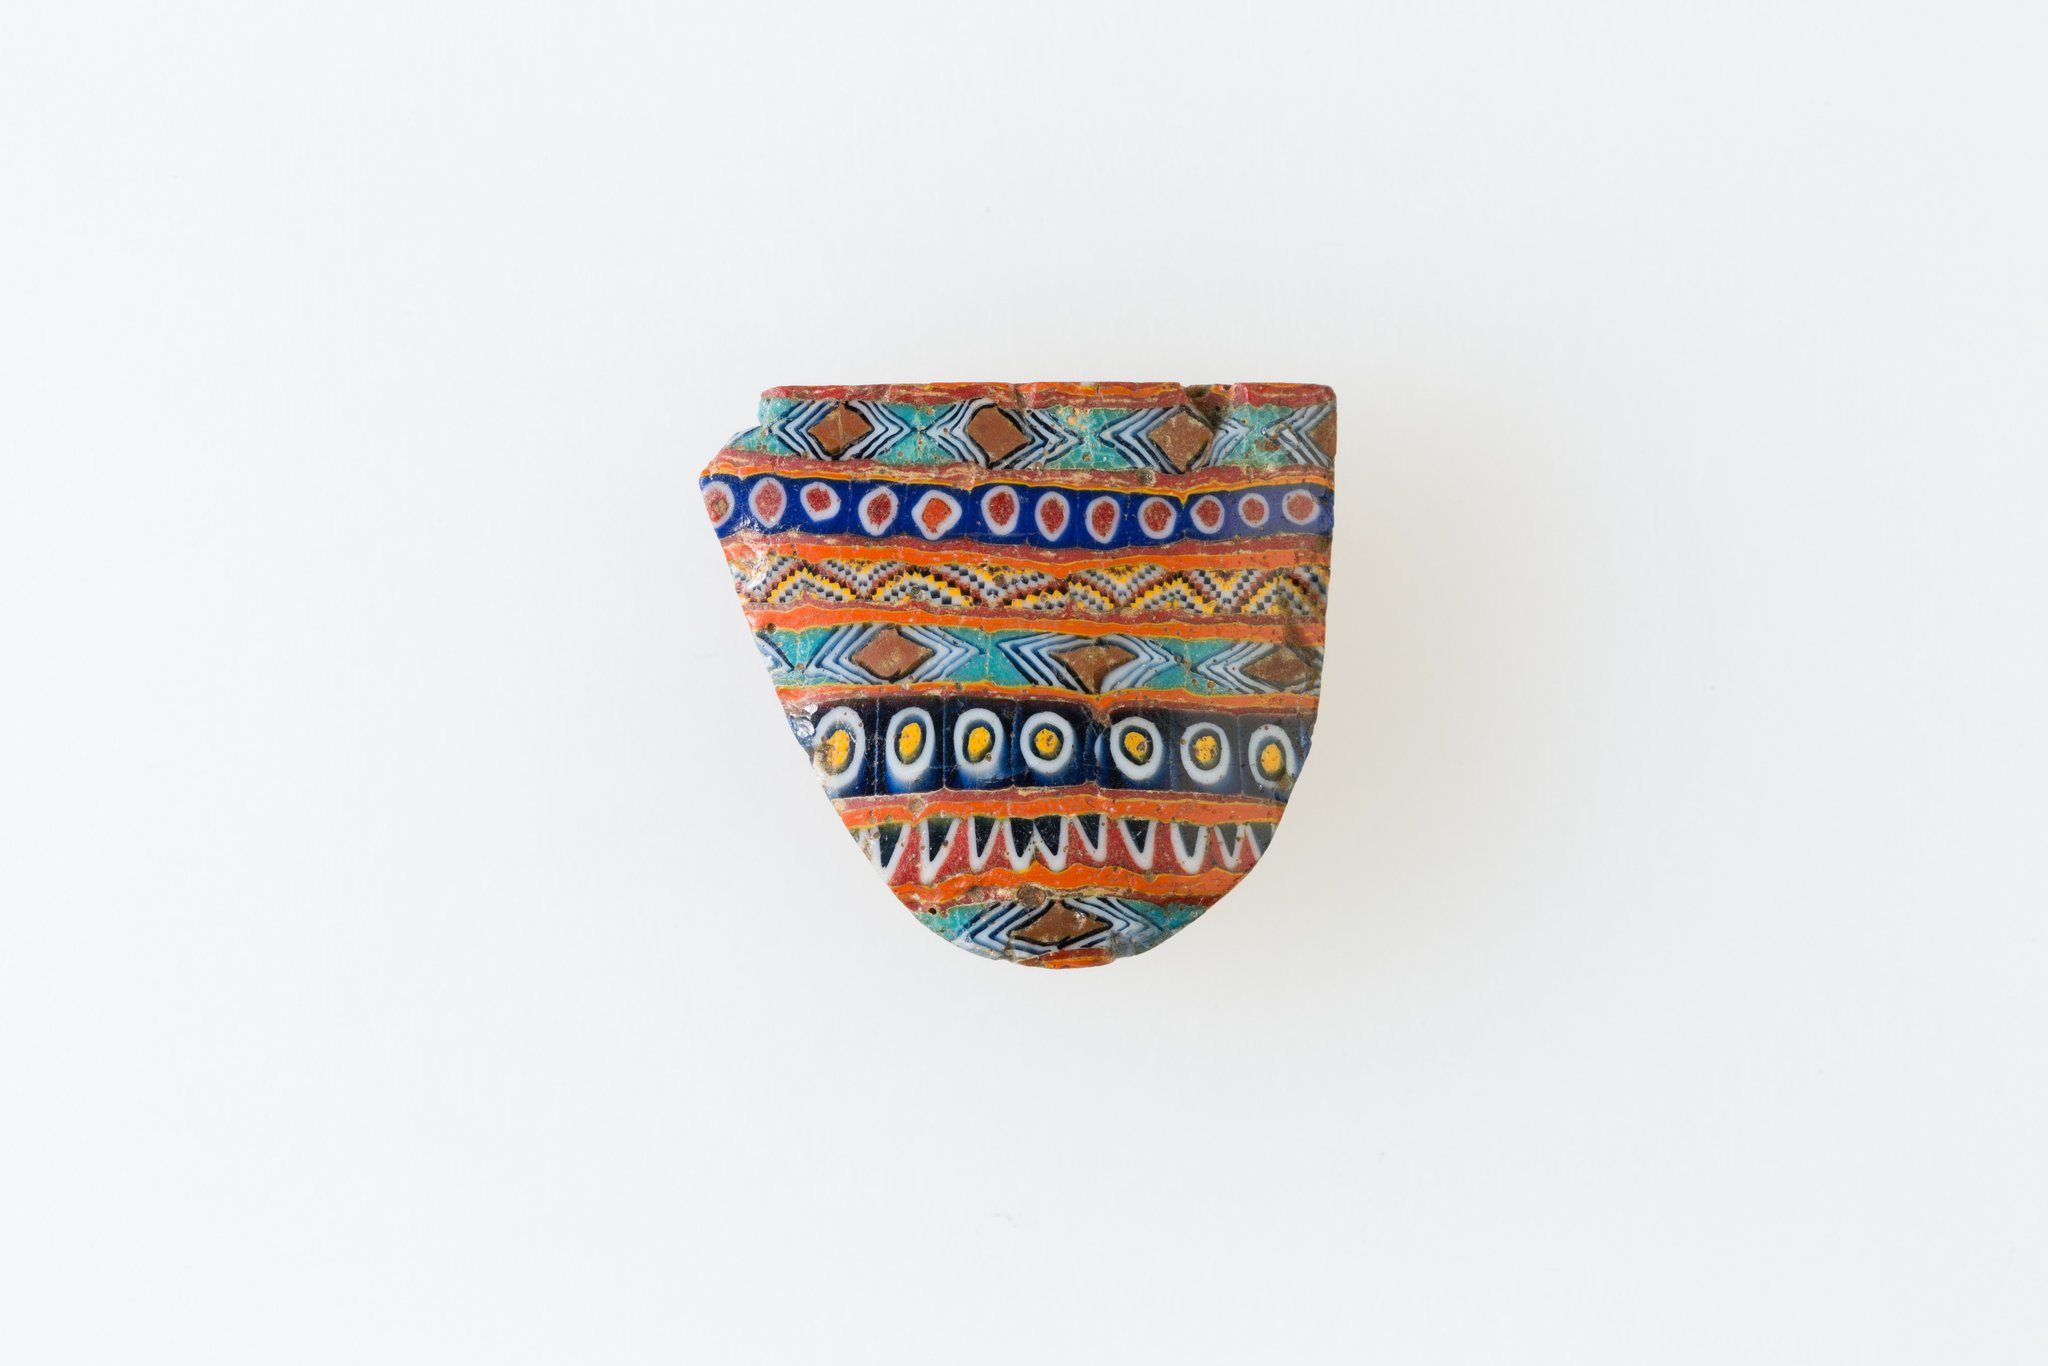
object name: inlay, bar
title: Semi-eliptical inlay, pattern formed by fused bars of diamonds, circles, dentelations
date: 100 BCE-100 CE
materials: glass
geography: egypt